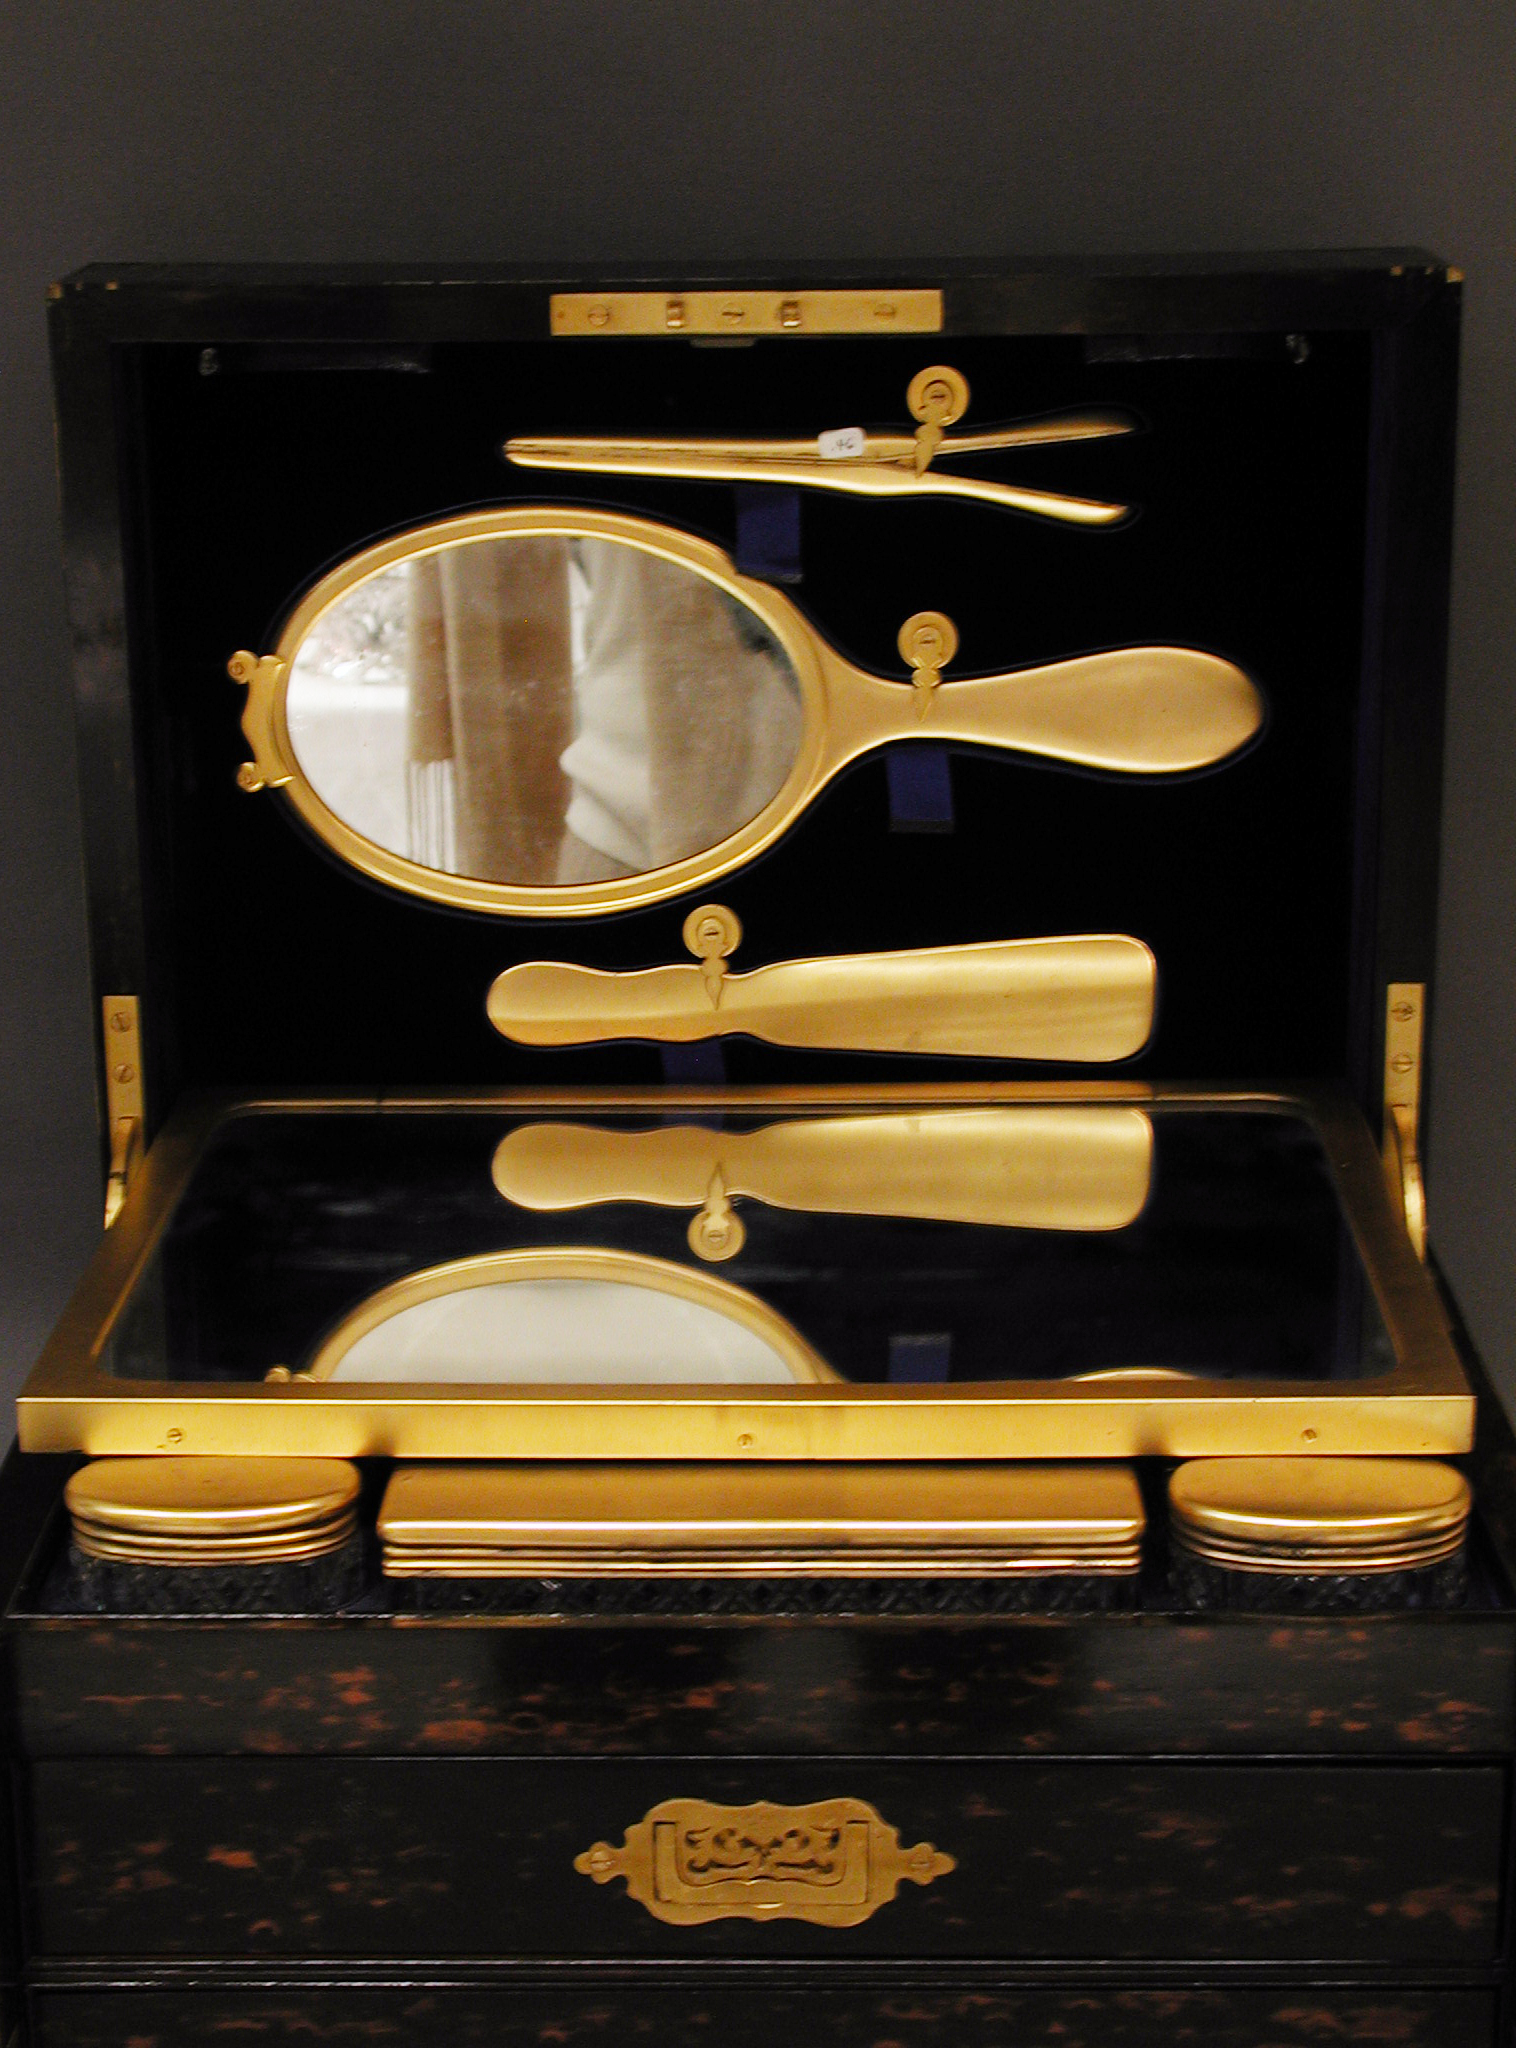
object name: mirror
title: Detachable mirror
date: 1874-1875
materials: glass, silver